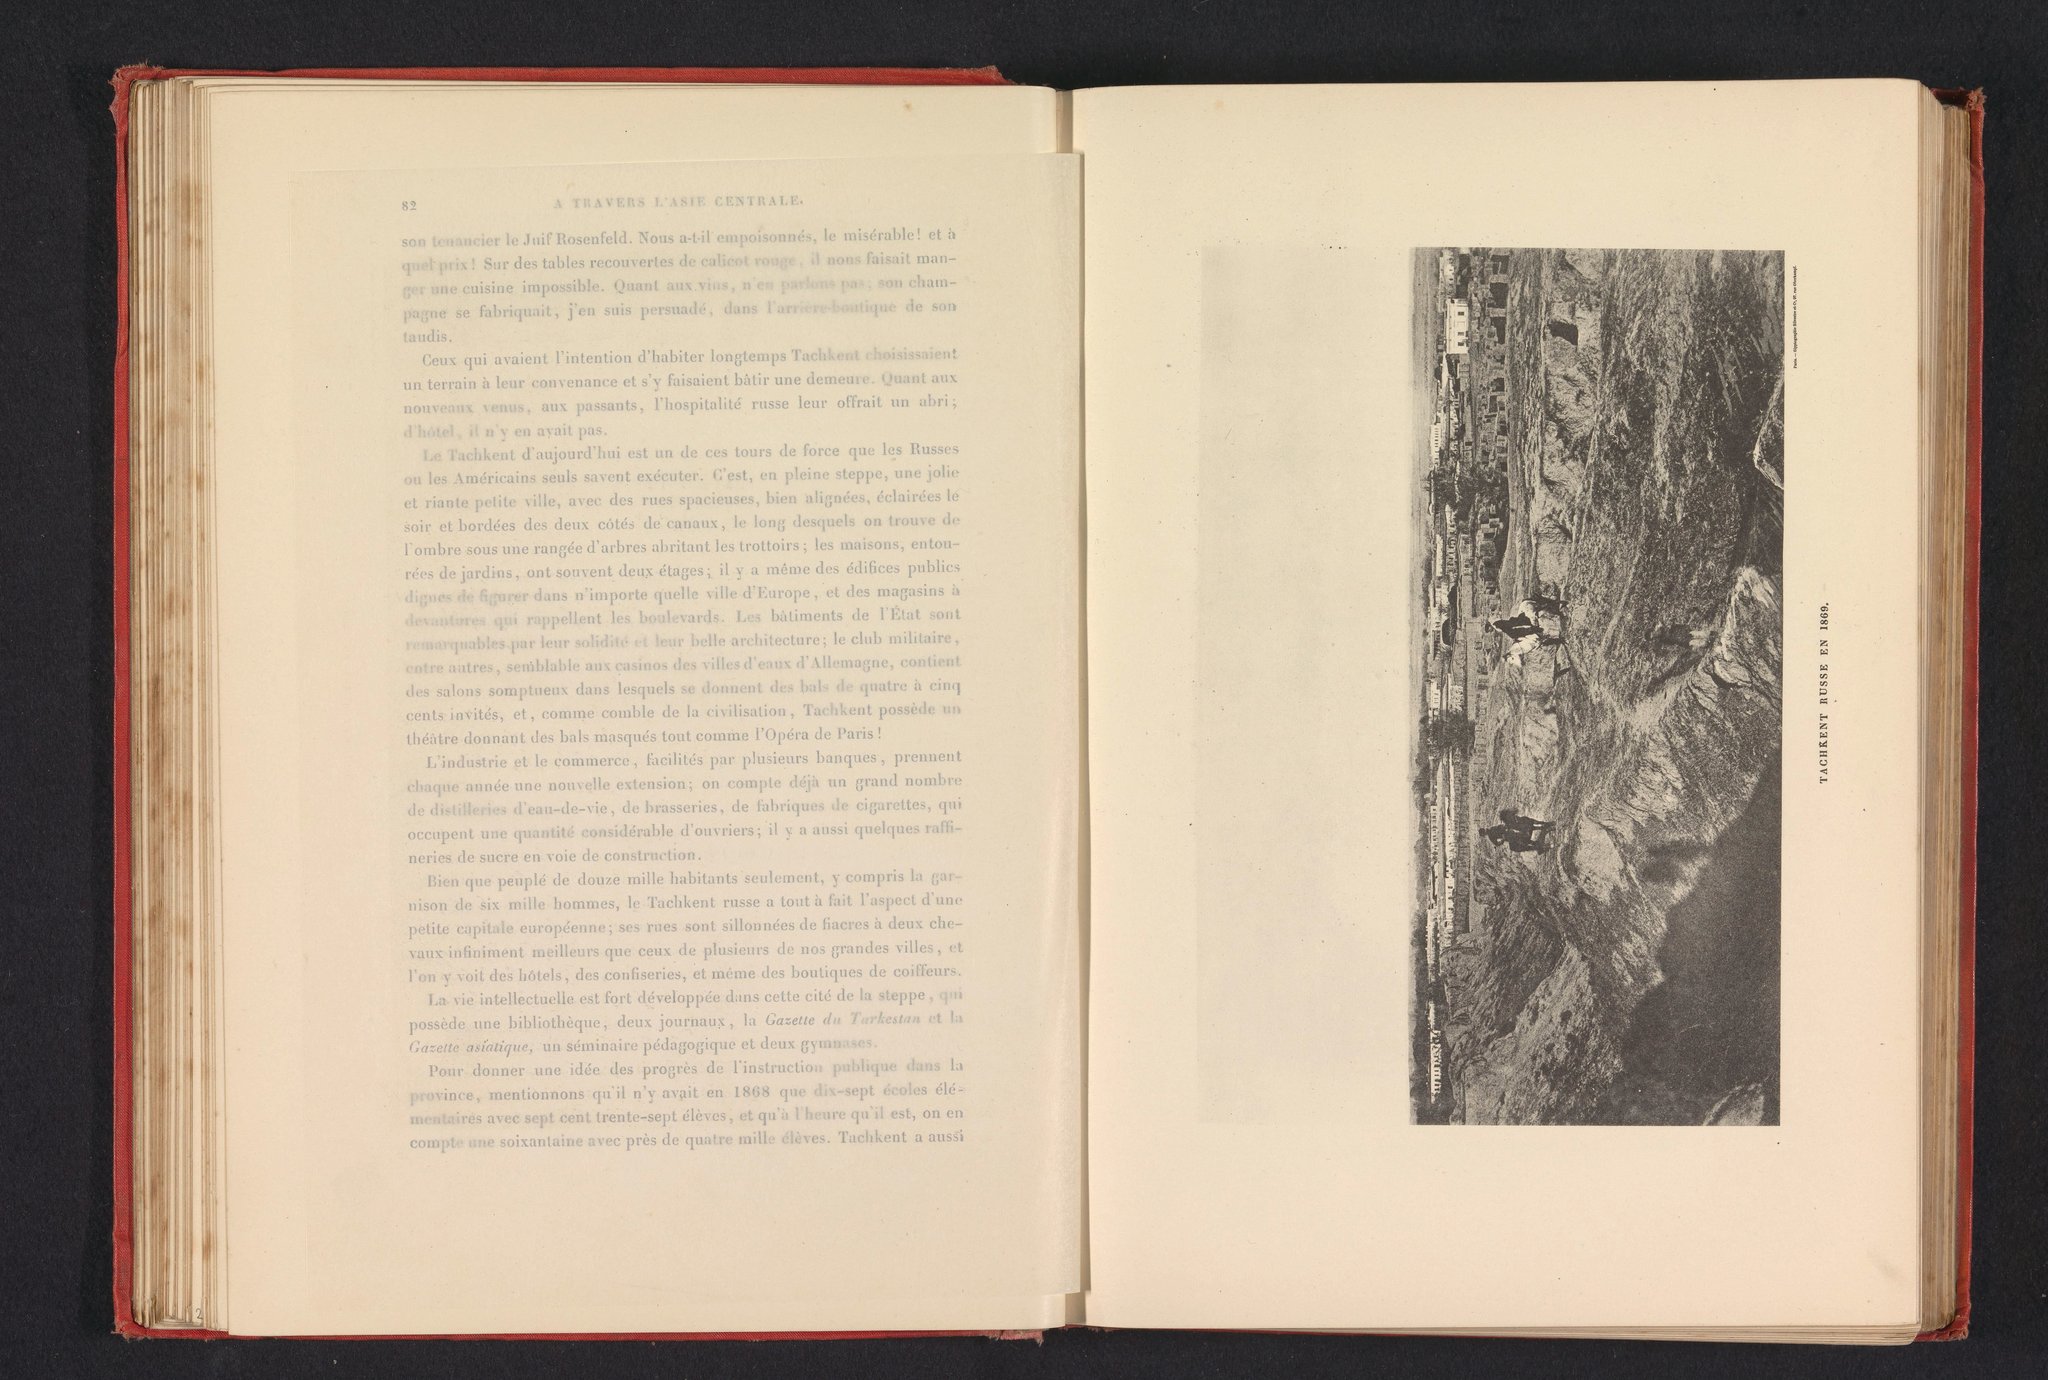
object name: photomechanical print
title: Tachkent Russe en 1869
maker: Anonymous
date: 1869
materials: paper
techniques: photograph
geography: paris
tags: city-view, and landscape with man-made constructions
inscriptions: name: ‘Silvestre et Cie, 97, rue Oberkampf.’